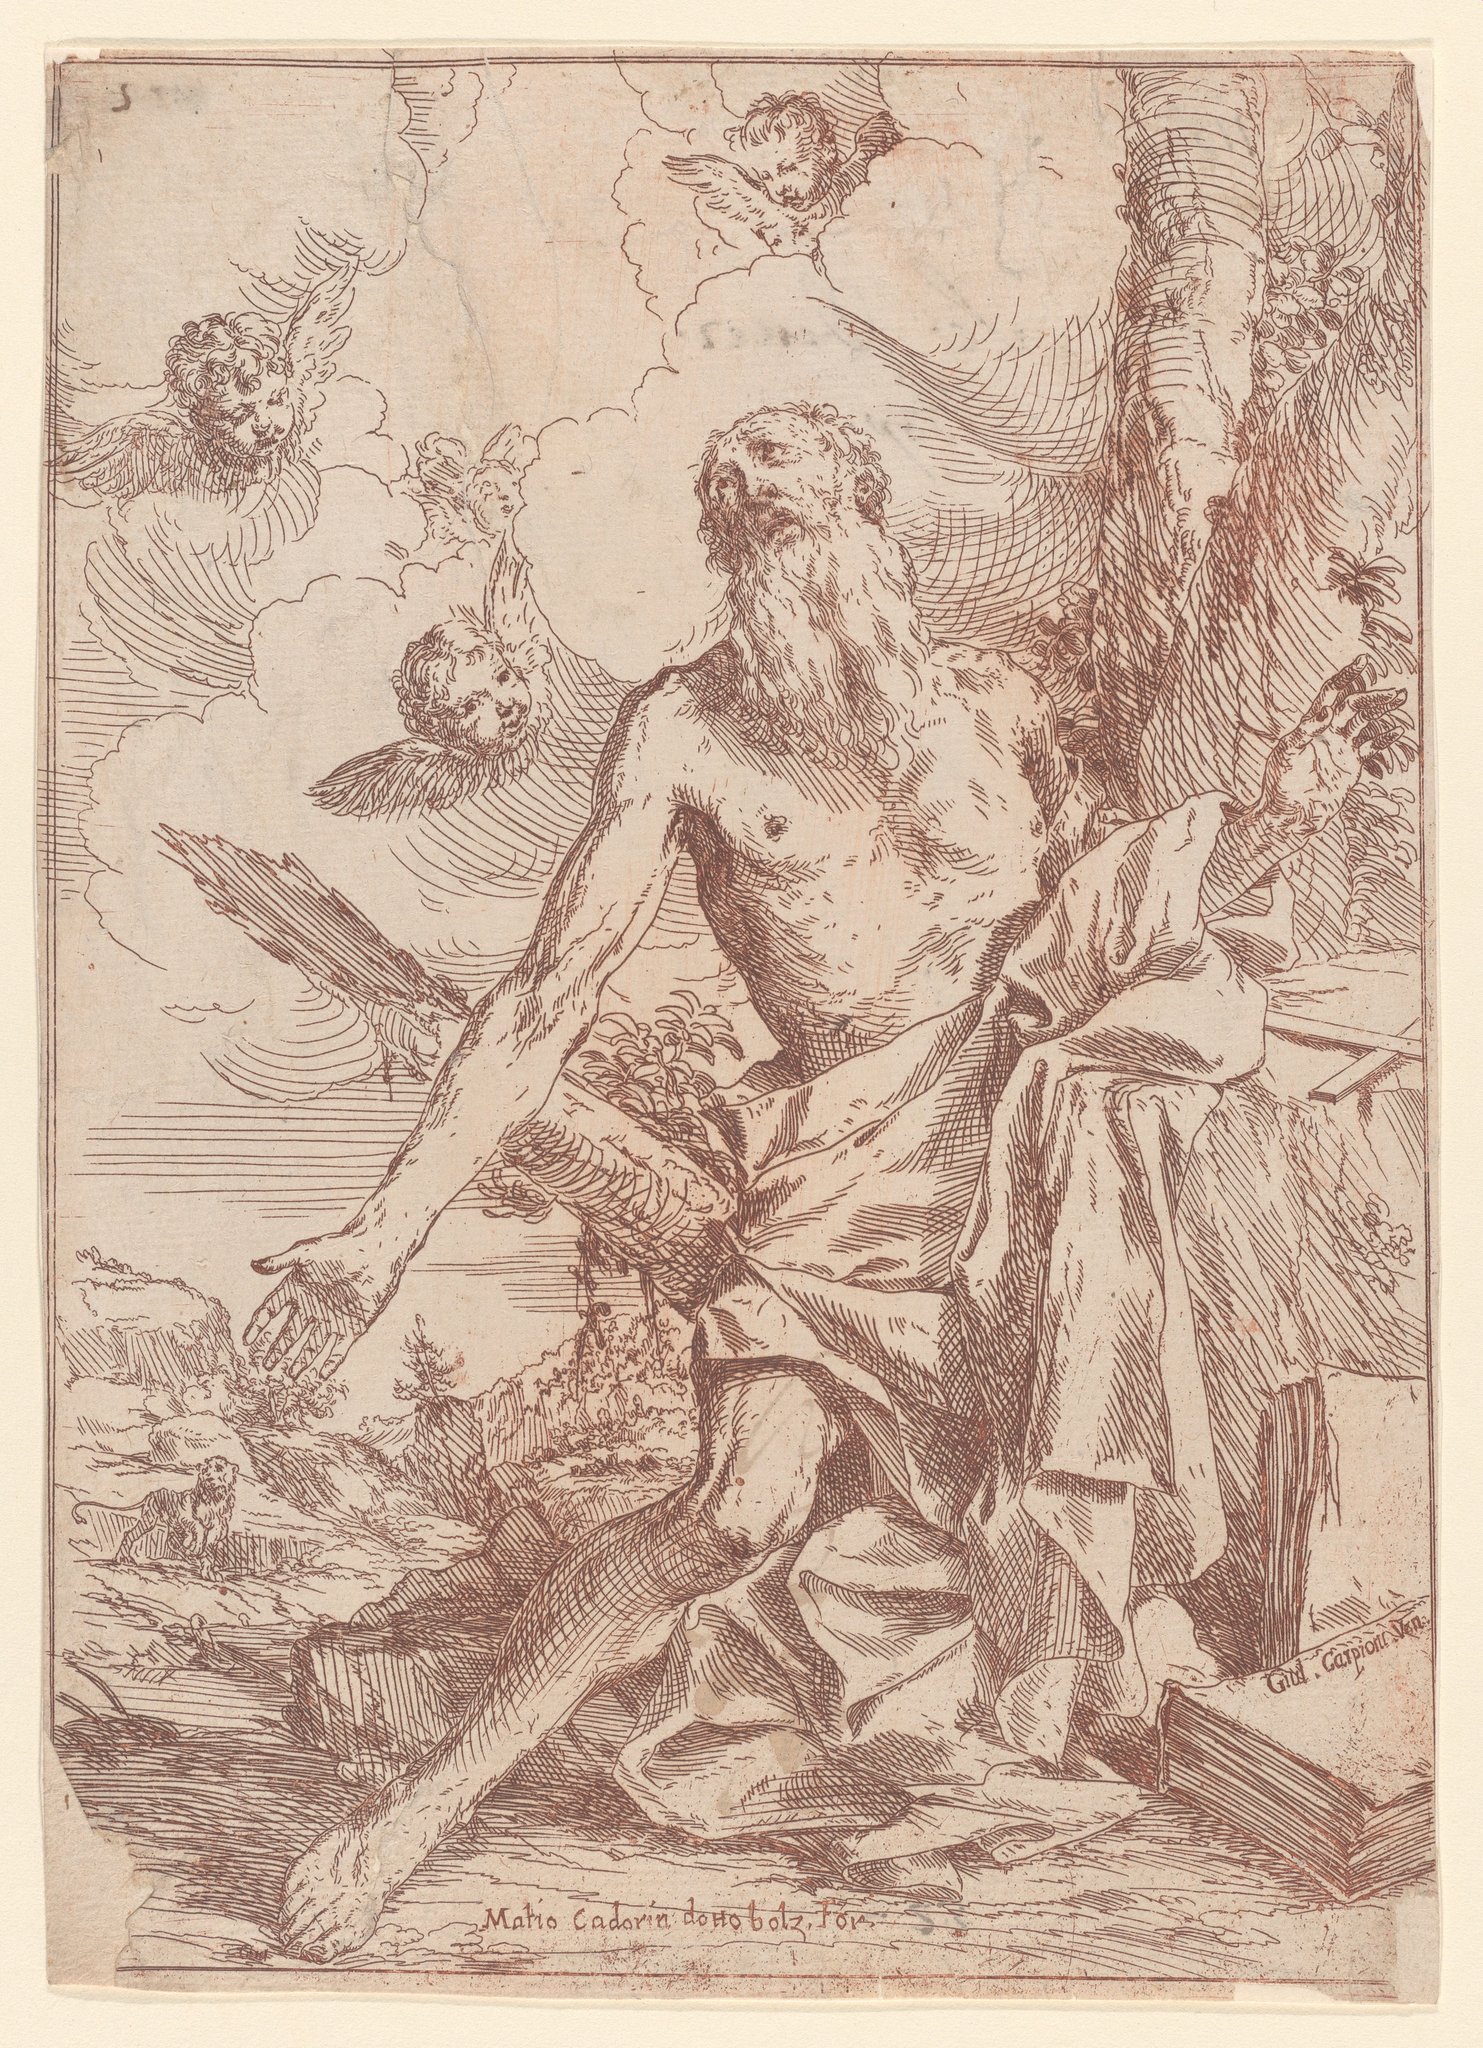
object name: print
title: Saint Jerome kneeling beside a tree with his arms outstretched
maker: giulio carpioni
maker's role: artist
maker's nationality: italian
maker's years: 1613-1678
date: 1640-1660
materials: ink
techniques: etching